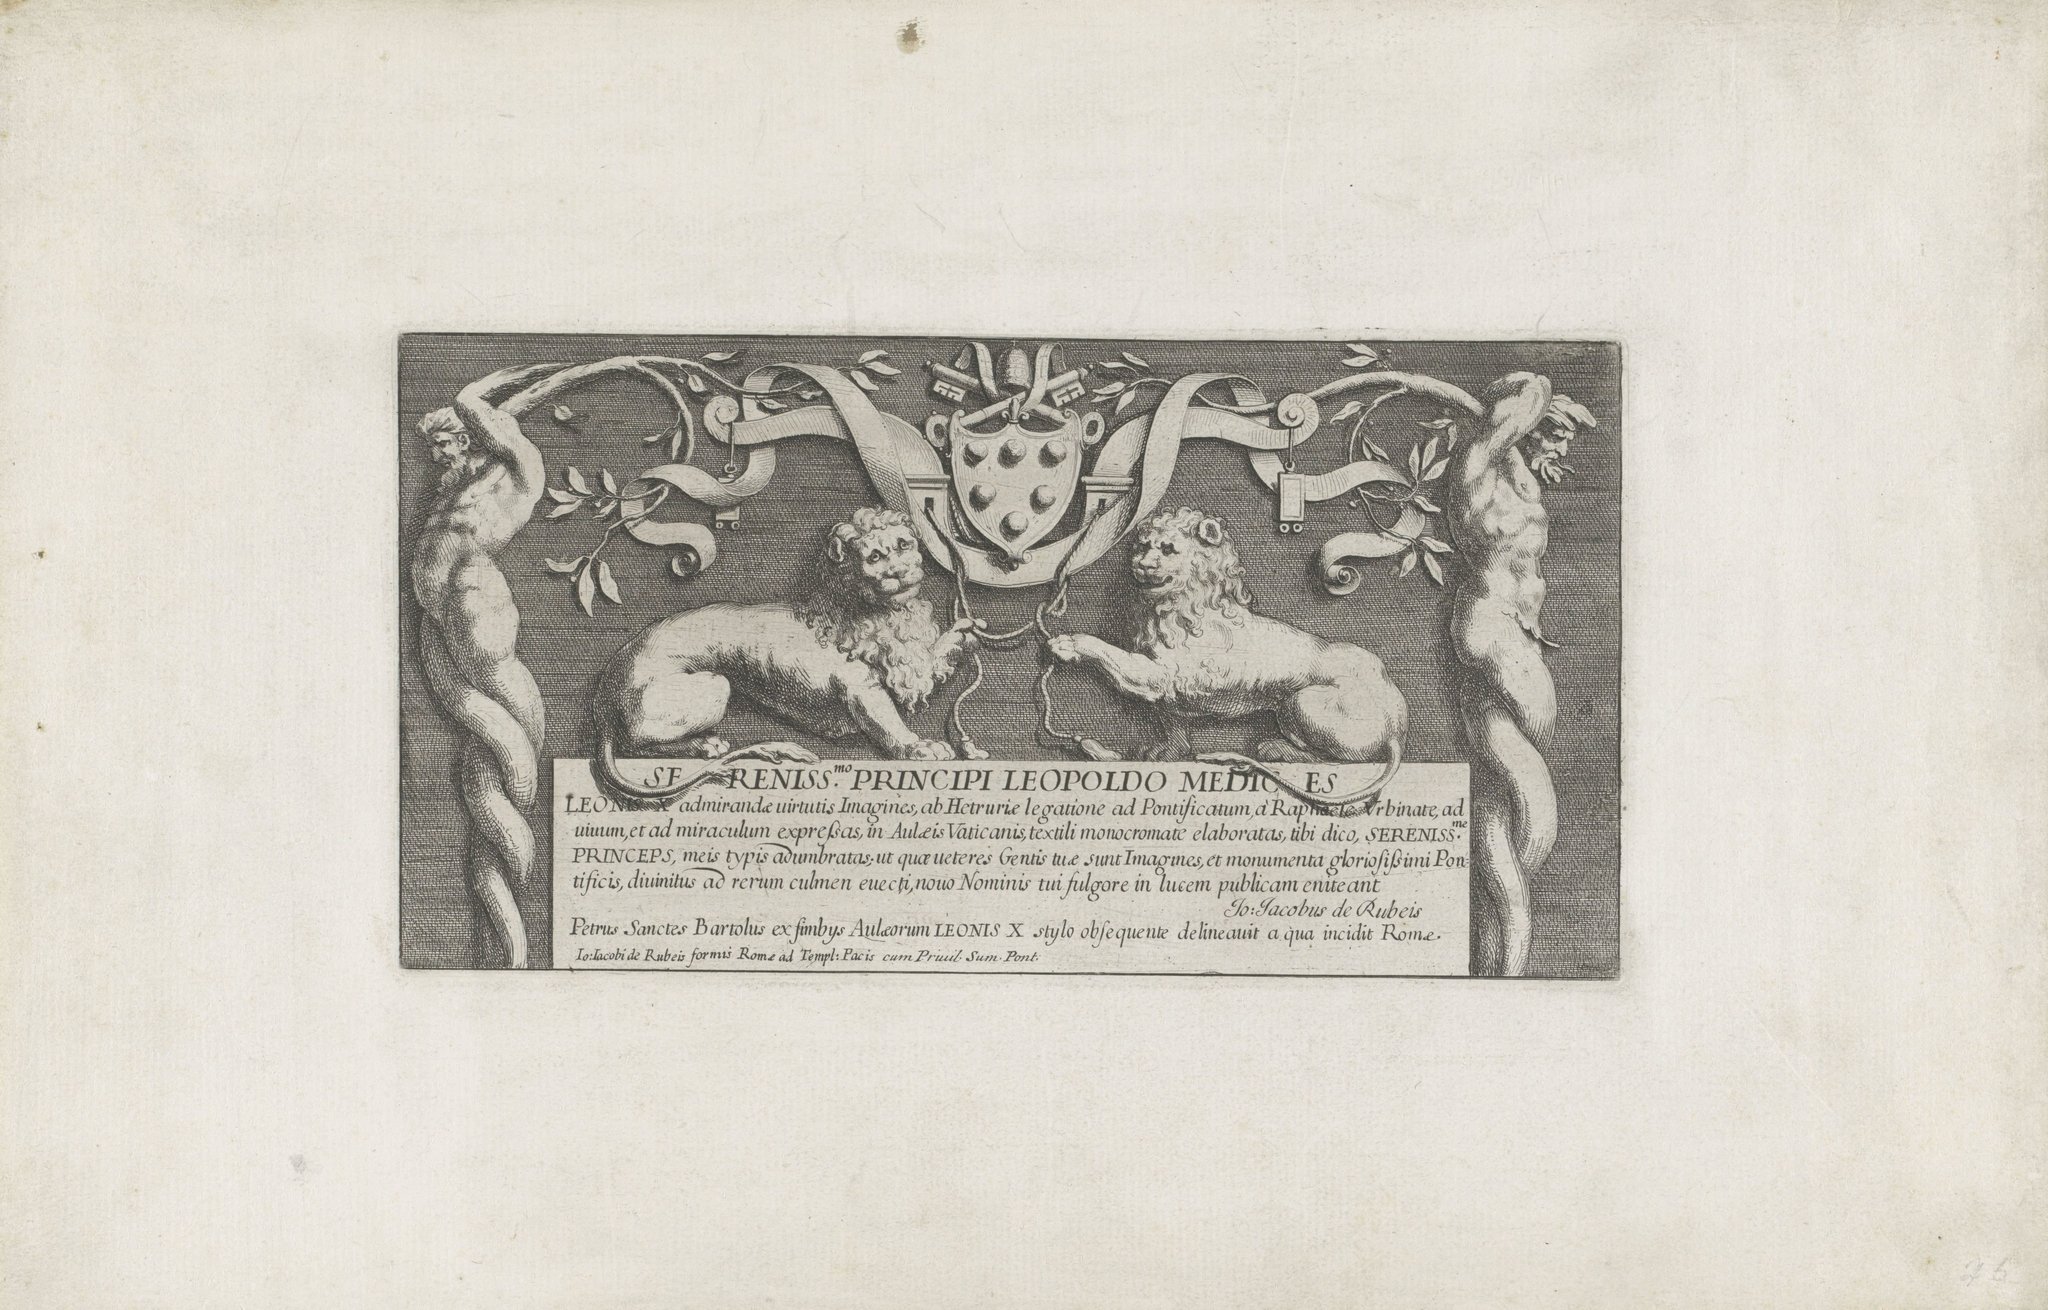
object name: print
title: Titelprent met twee leeuwen en twee mannen die half tot boom zijn vergroeid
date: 1645-1700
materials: paper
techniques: engraving, etching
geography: vatican city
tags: rome, leo x, coat of arms (symbol of sovereignty), beasts of prey, predatory animals: lion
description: Titelprent met twee leeuwen en twee mannen die half tot boom zijn vergroeid. Midden boven het wapen van paus Leo X. Midden onder een kader met tekst in het Latijn.